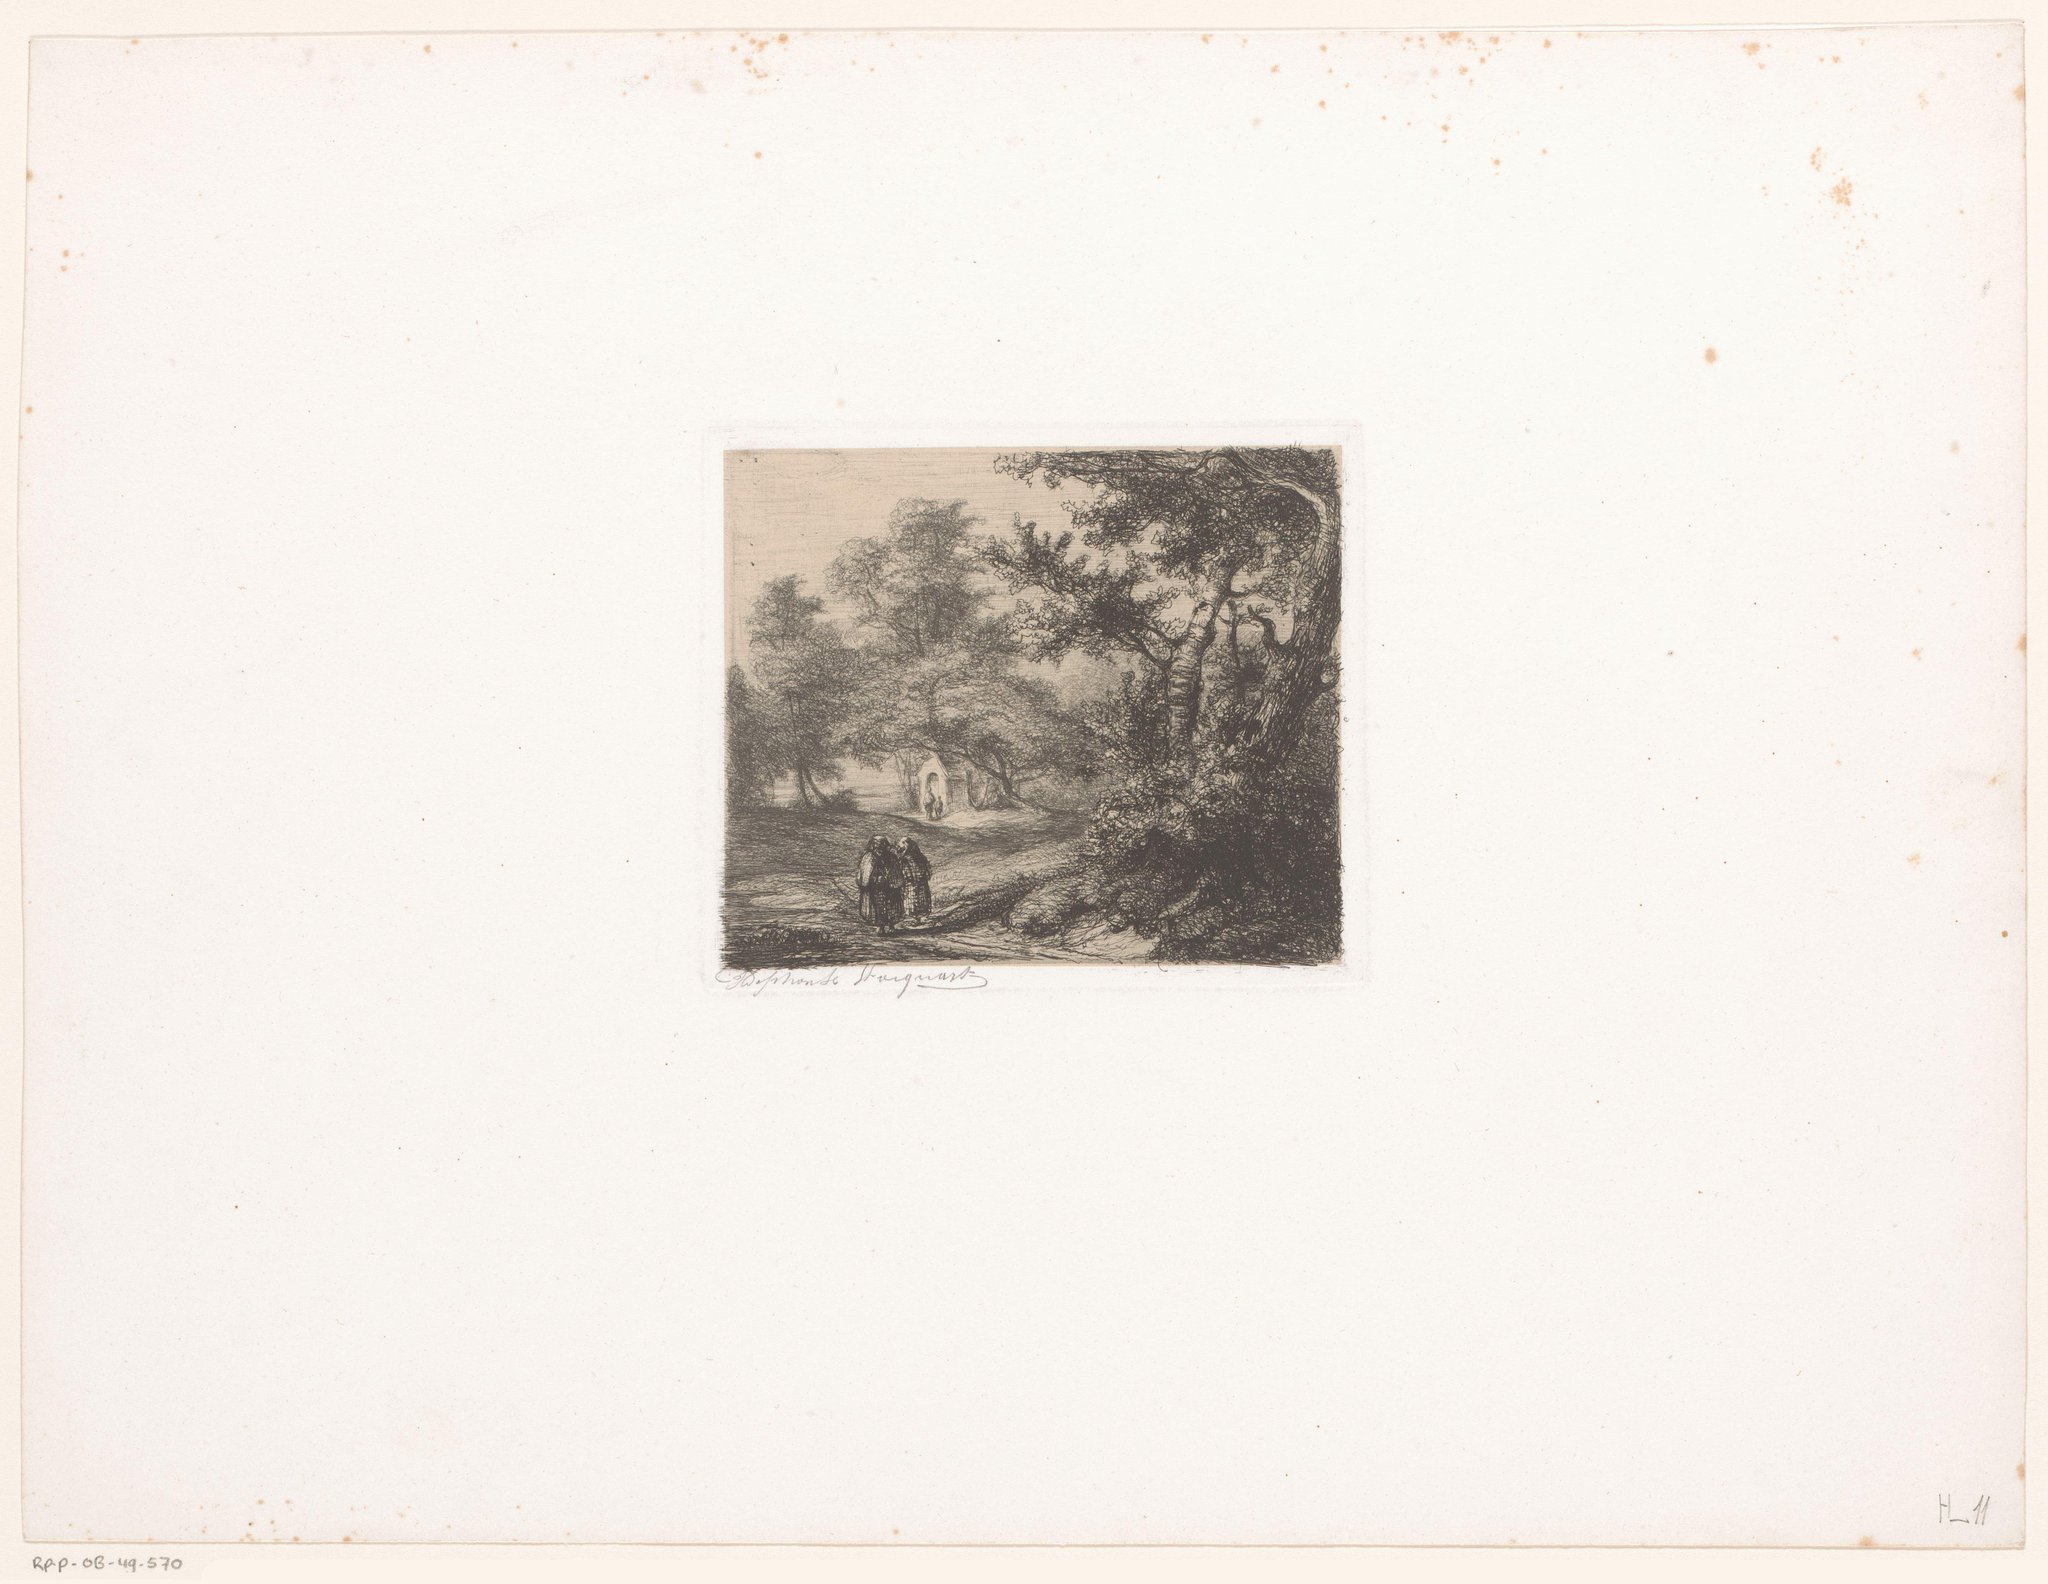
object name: print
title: Landschap met kapel en twee monniken op de voorgrond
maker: ildephonse stocquart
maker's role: print maker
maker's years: 1819-1889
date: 1829-1879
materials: paper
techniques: drypoint, etching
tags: monk(s), friar(s), church (exterior) - qq - small church, chapel, forest, wood (+ landscape with figures, staffage)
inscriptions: collector's mark: Lugt 2228